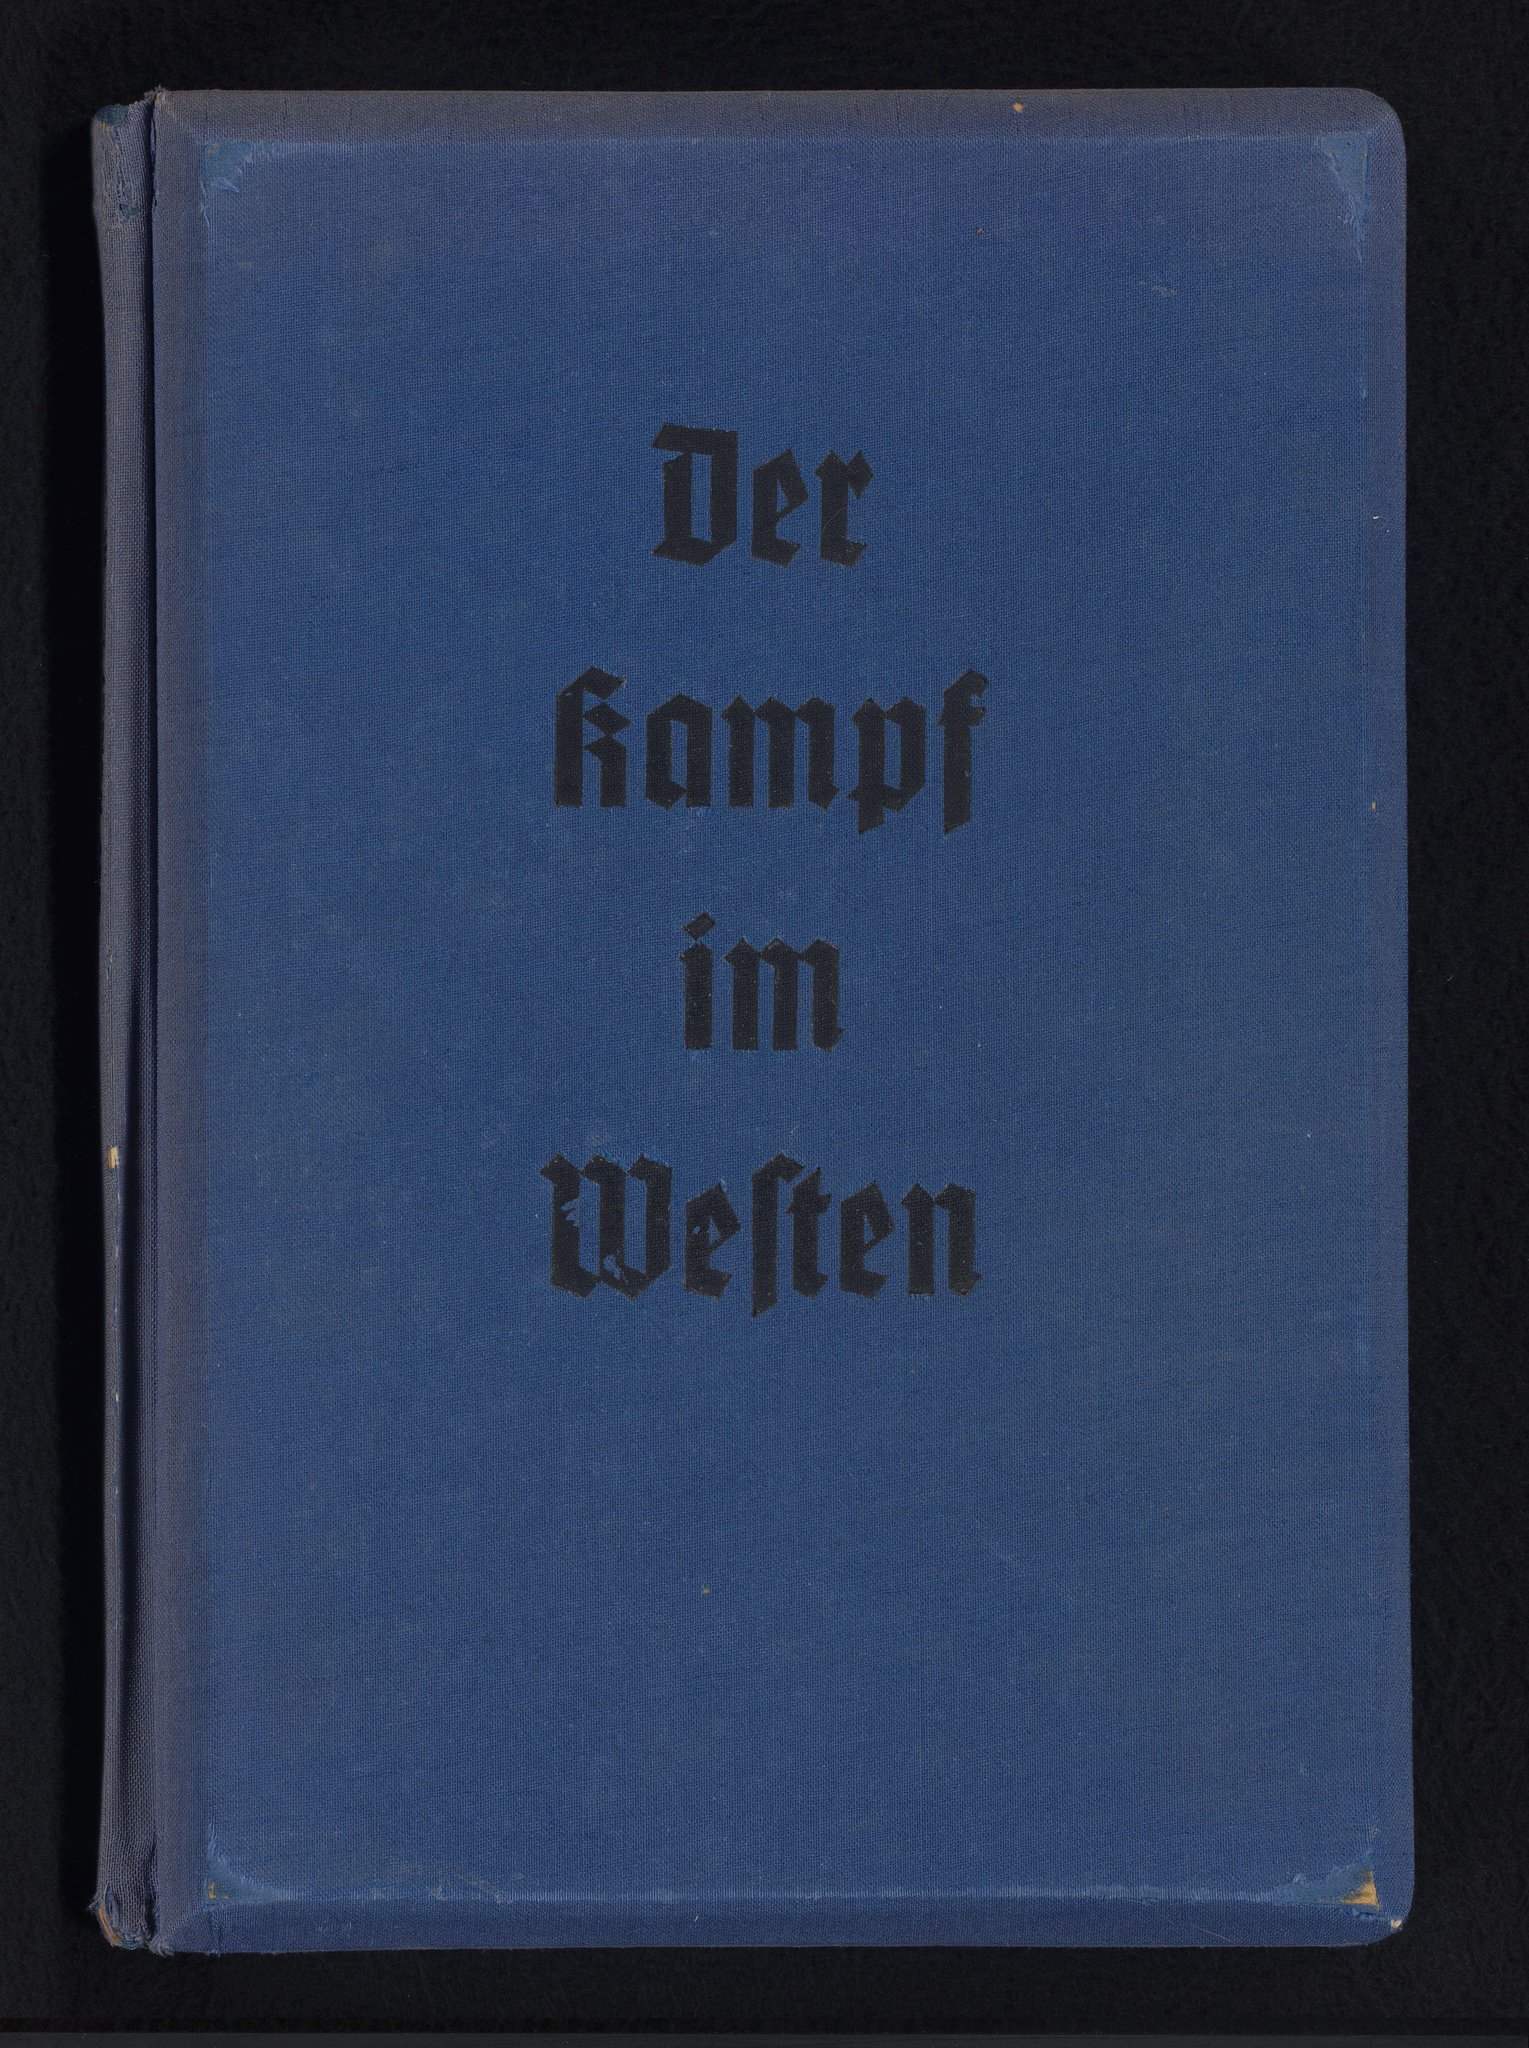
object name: stereoscope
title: Der Kampf im Westen - Die Soldaten des Führers im Felde II. Band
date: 1940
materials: cardboard, linen, metal, paper, photographic support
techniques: gelatin silver print, printing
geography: munich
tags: private soldier, war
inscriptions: inscription: ‘Der Reichskommissar für die besetzten niederländischen Gebiete 3’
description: Boek met in de band drie stapels stereofoto's en een stereoscoop. Afgebeeld zijn Duitse soldaten in Nederland en België tijdens de Tweede Wereldoorlog. Verder bevat het boek enkele platen in vierkleurenautotypie die tussen de tekstbladen zijn gebonden. Bij deze platen zijn de achternamen van de fotografen vermeld, te weten Bauer, Engel, Kindermann, Schlickum en Folkerts. In de tekst wordt beschreven hoe de strijd verloopt op Belgisch en Nederlands grondgebied. Achterin het boek bevindt zich een lijst met beschrijvingen van de honderd stereofoto's.